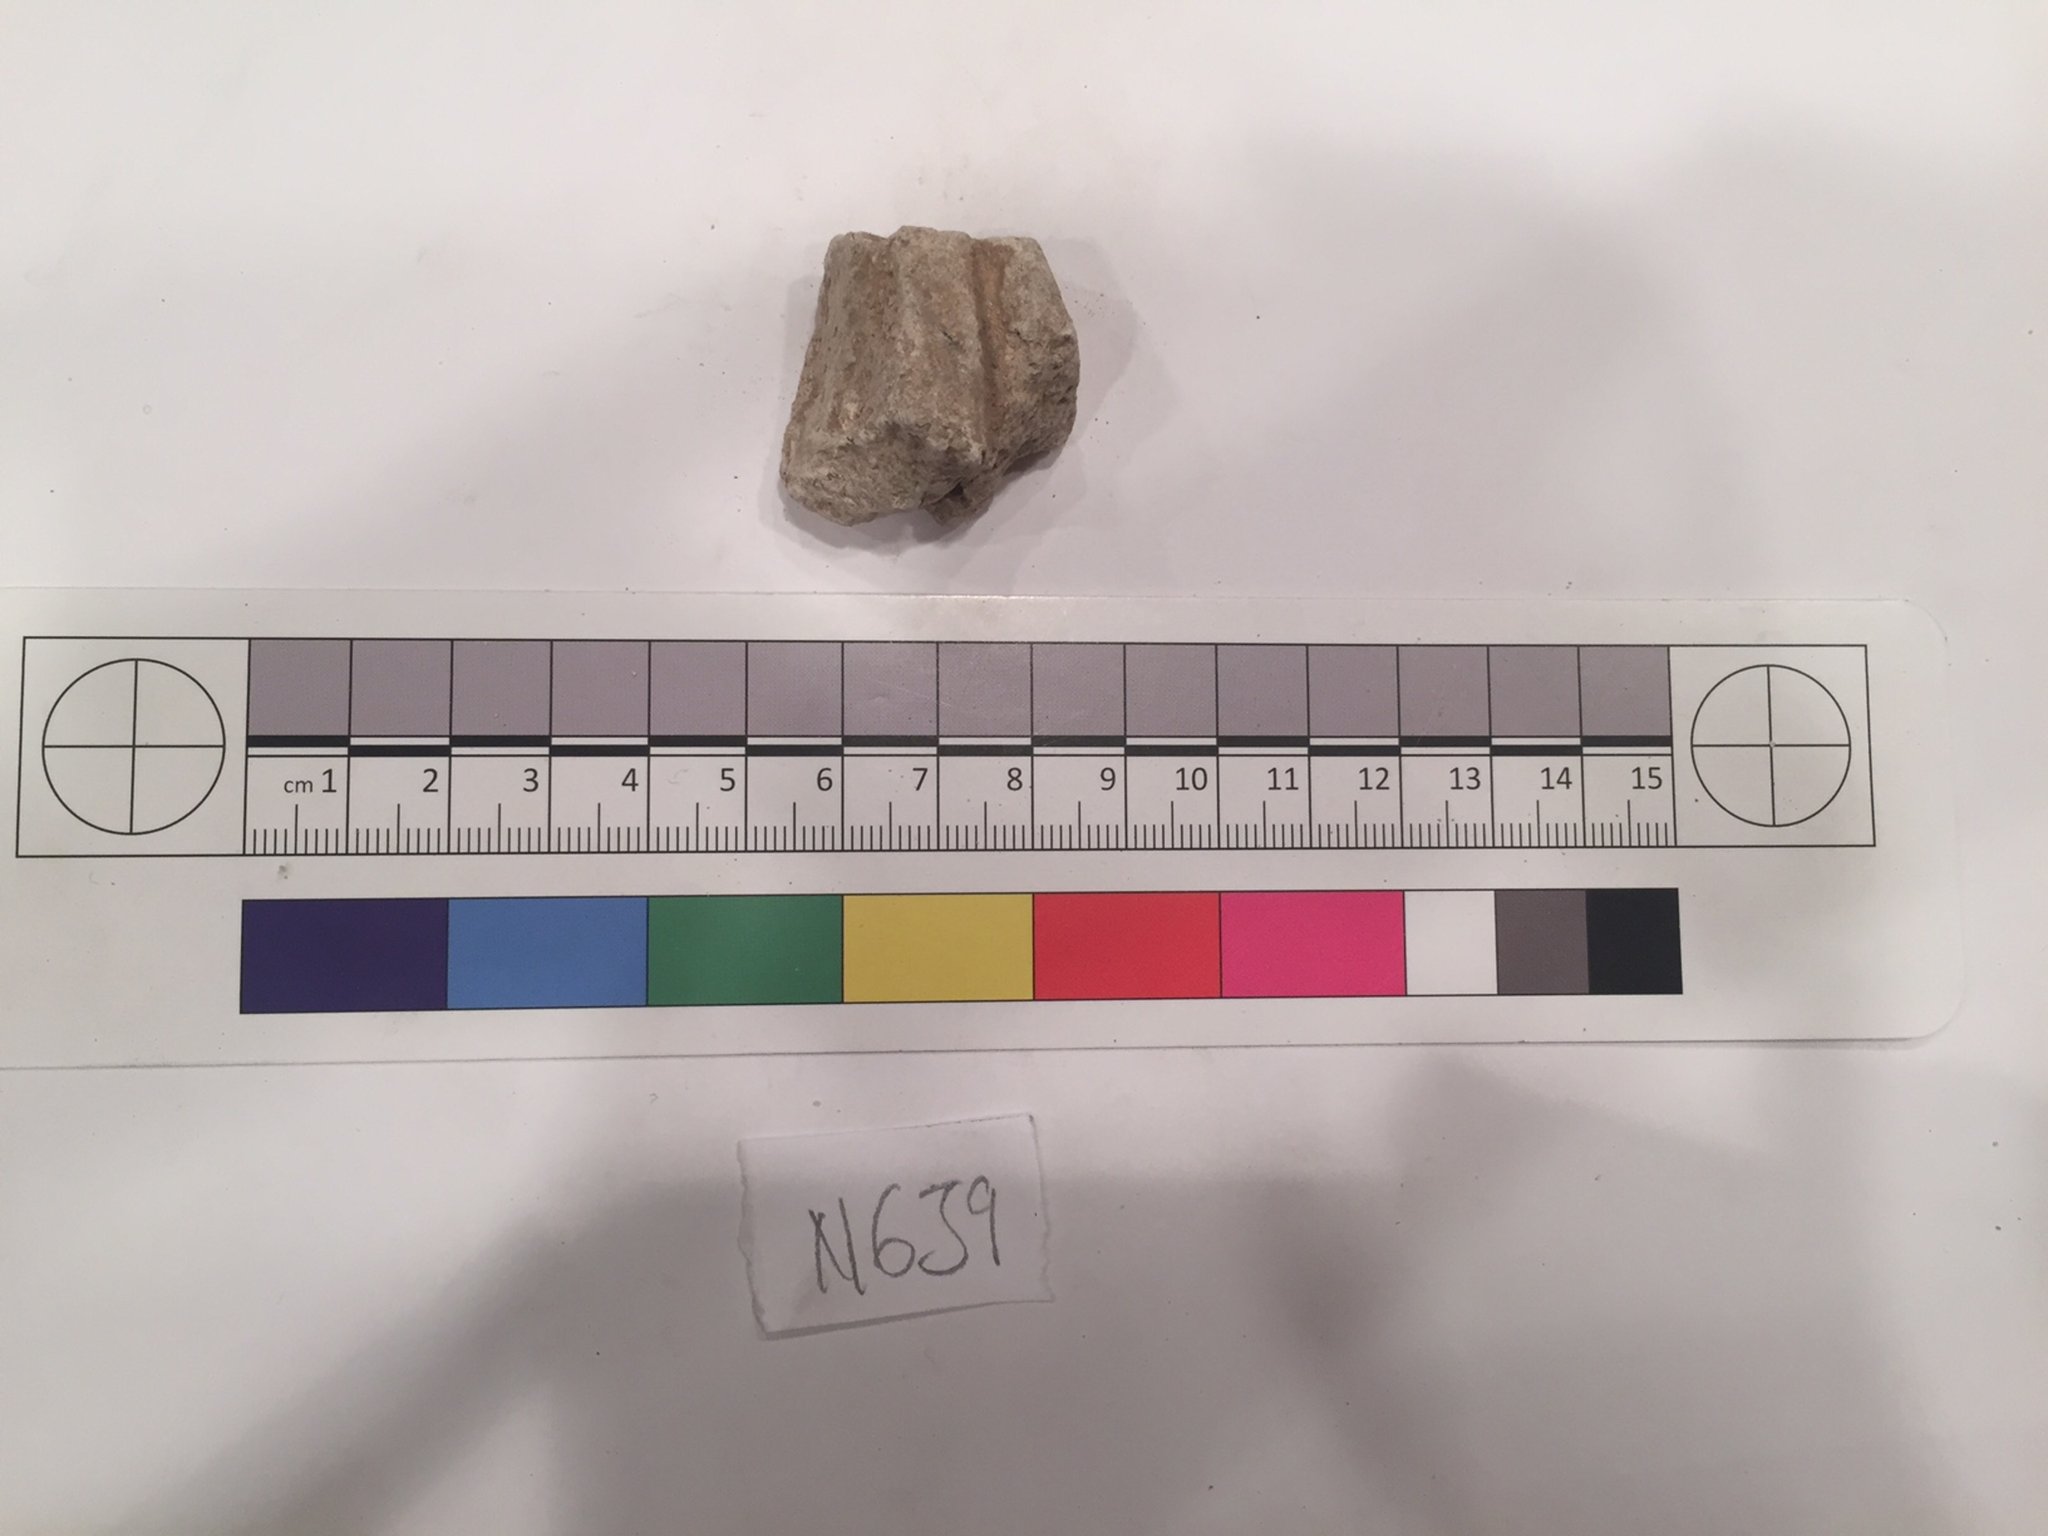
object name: fragment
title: Stucco Fragment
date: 701-1200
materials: plaster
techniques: carving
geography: iran